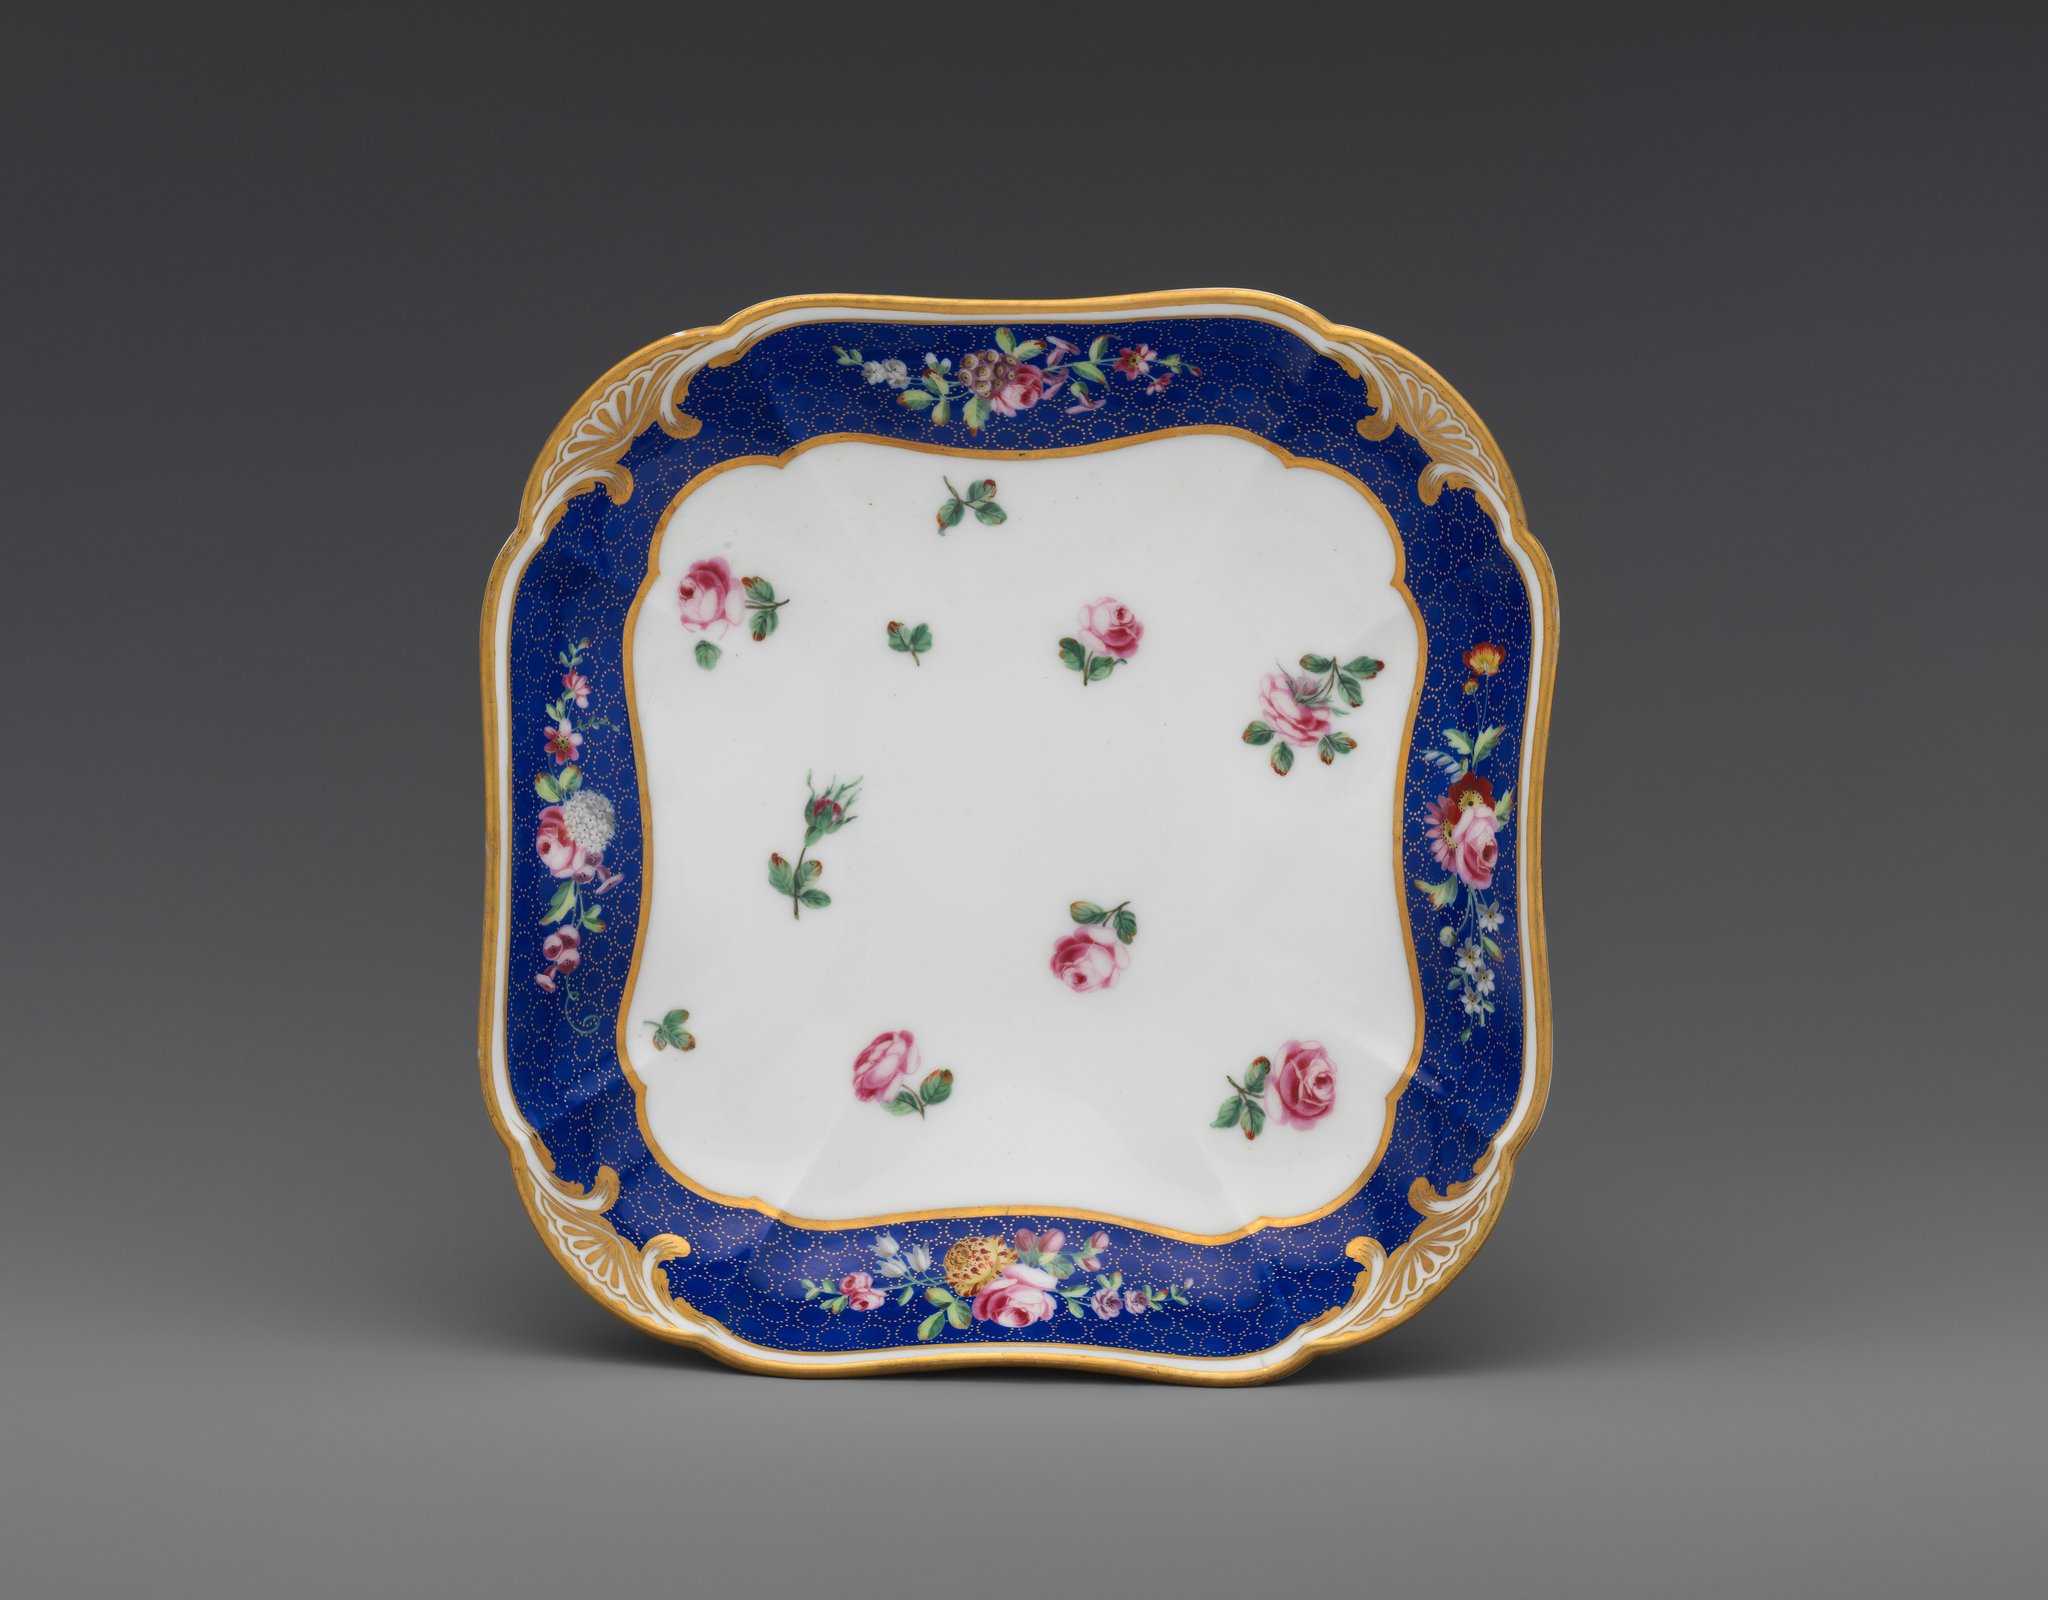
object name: fruit dish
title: Fruit dish (compotier carré)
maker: sèvres manufactory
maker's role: manufactory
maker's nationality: french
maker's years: 1740-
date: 1771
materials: soft paste porcelain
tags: flowers